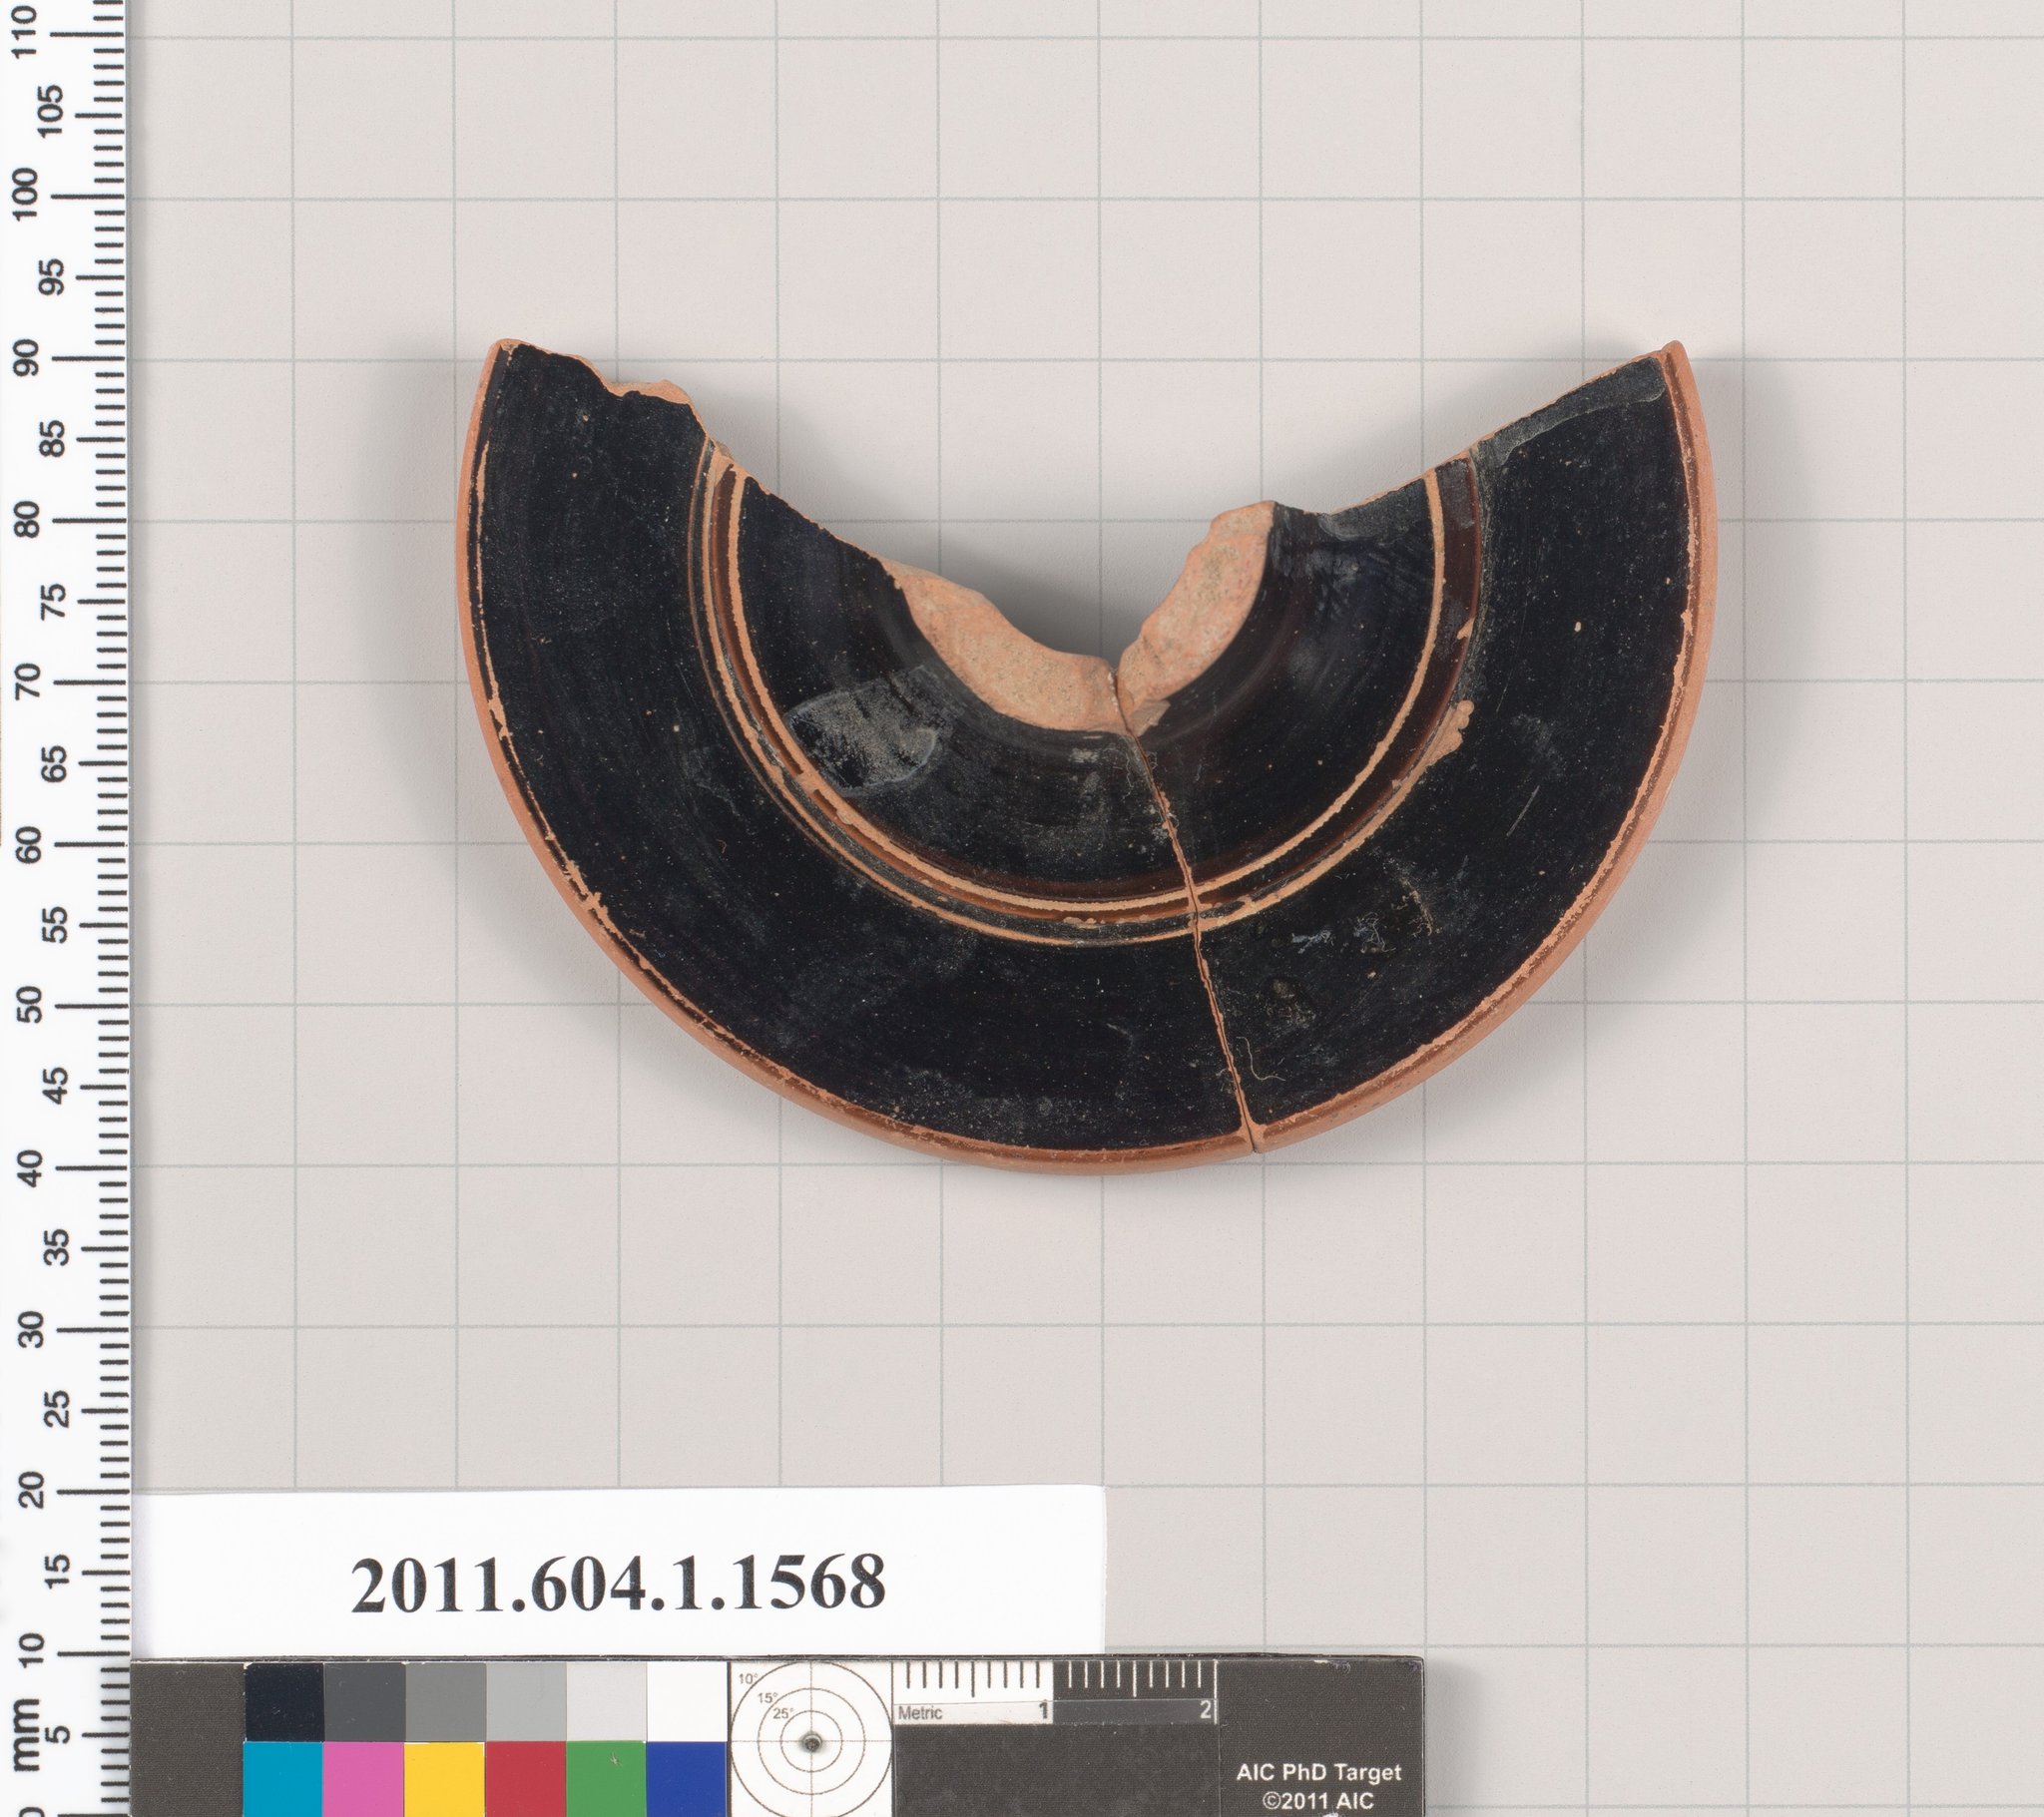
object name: kylix fragment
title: Terracotta fragment of a kylix (drinking cup)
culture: greek, attic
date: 500-401 BCE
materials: terracotta